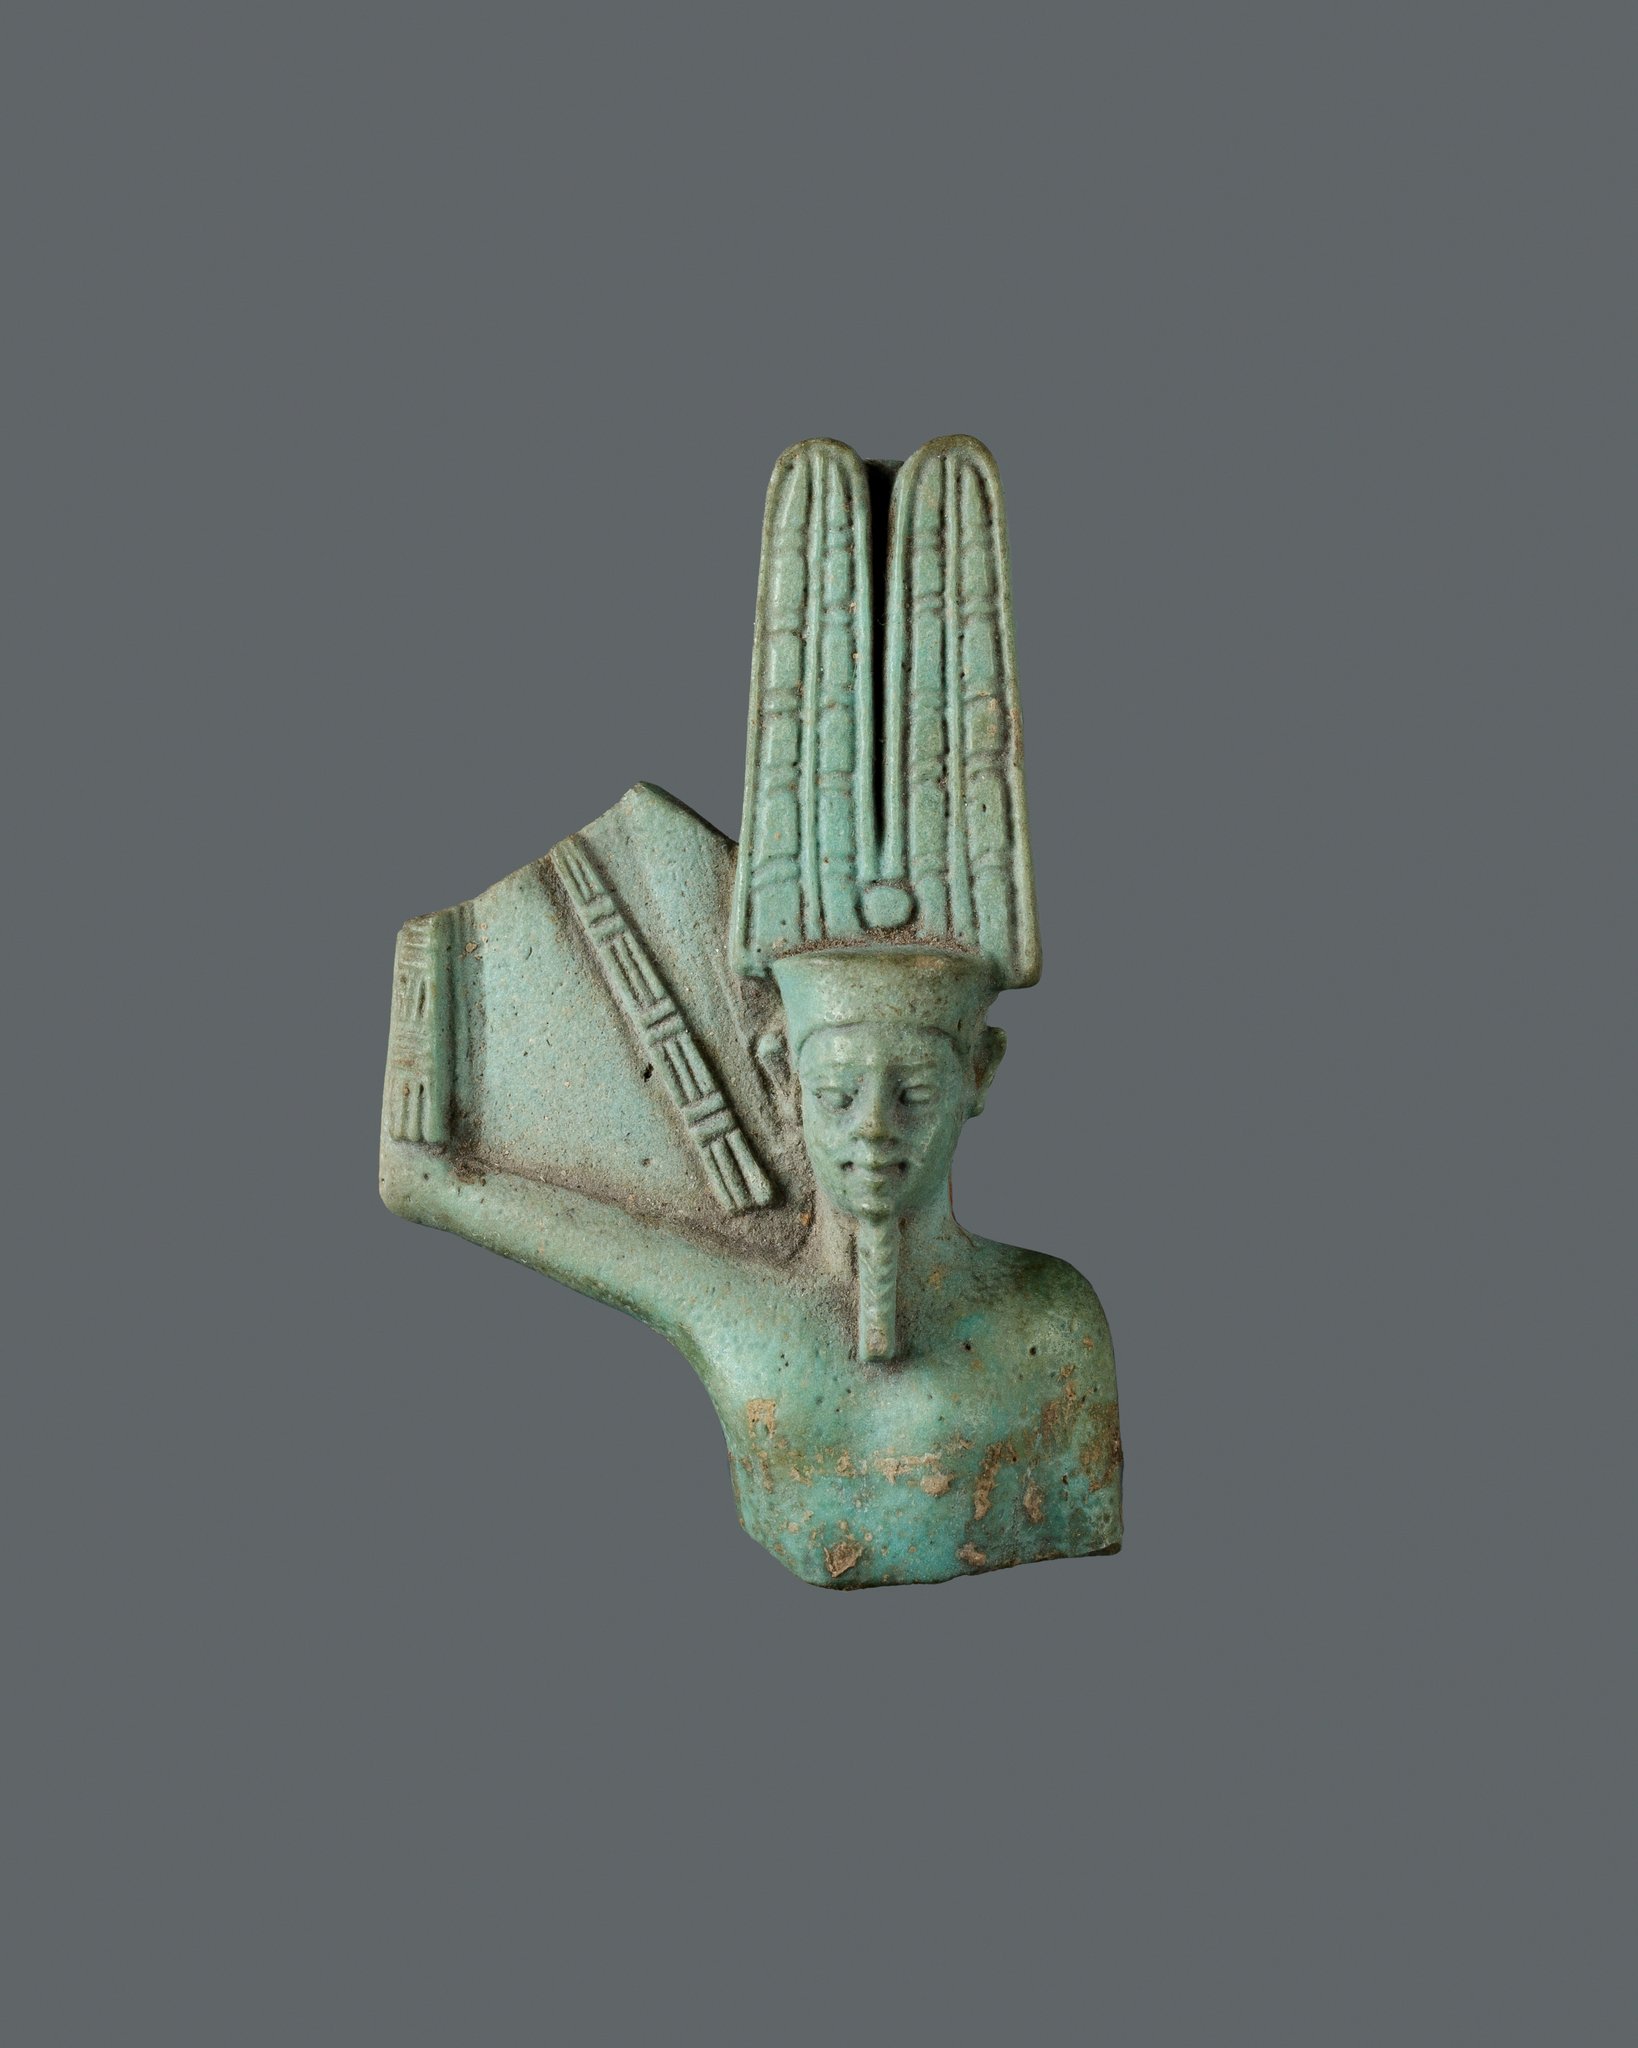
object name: statuette fragment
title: Fragment of Min statuette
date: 664-630 BCE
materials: faience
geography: egypt